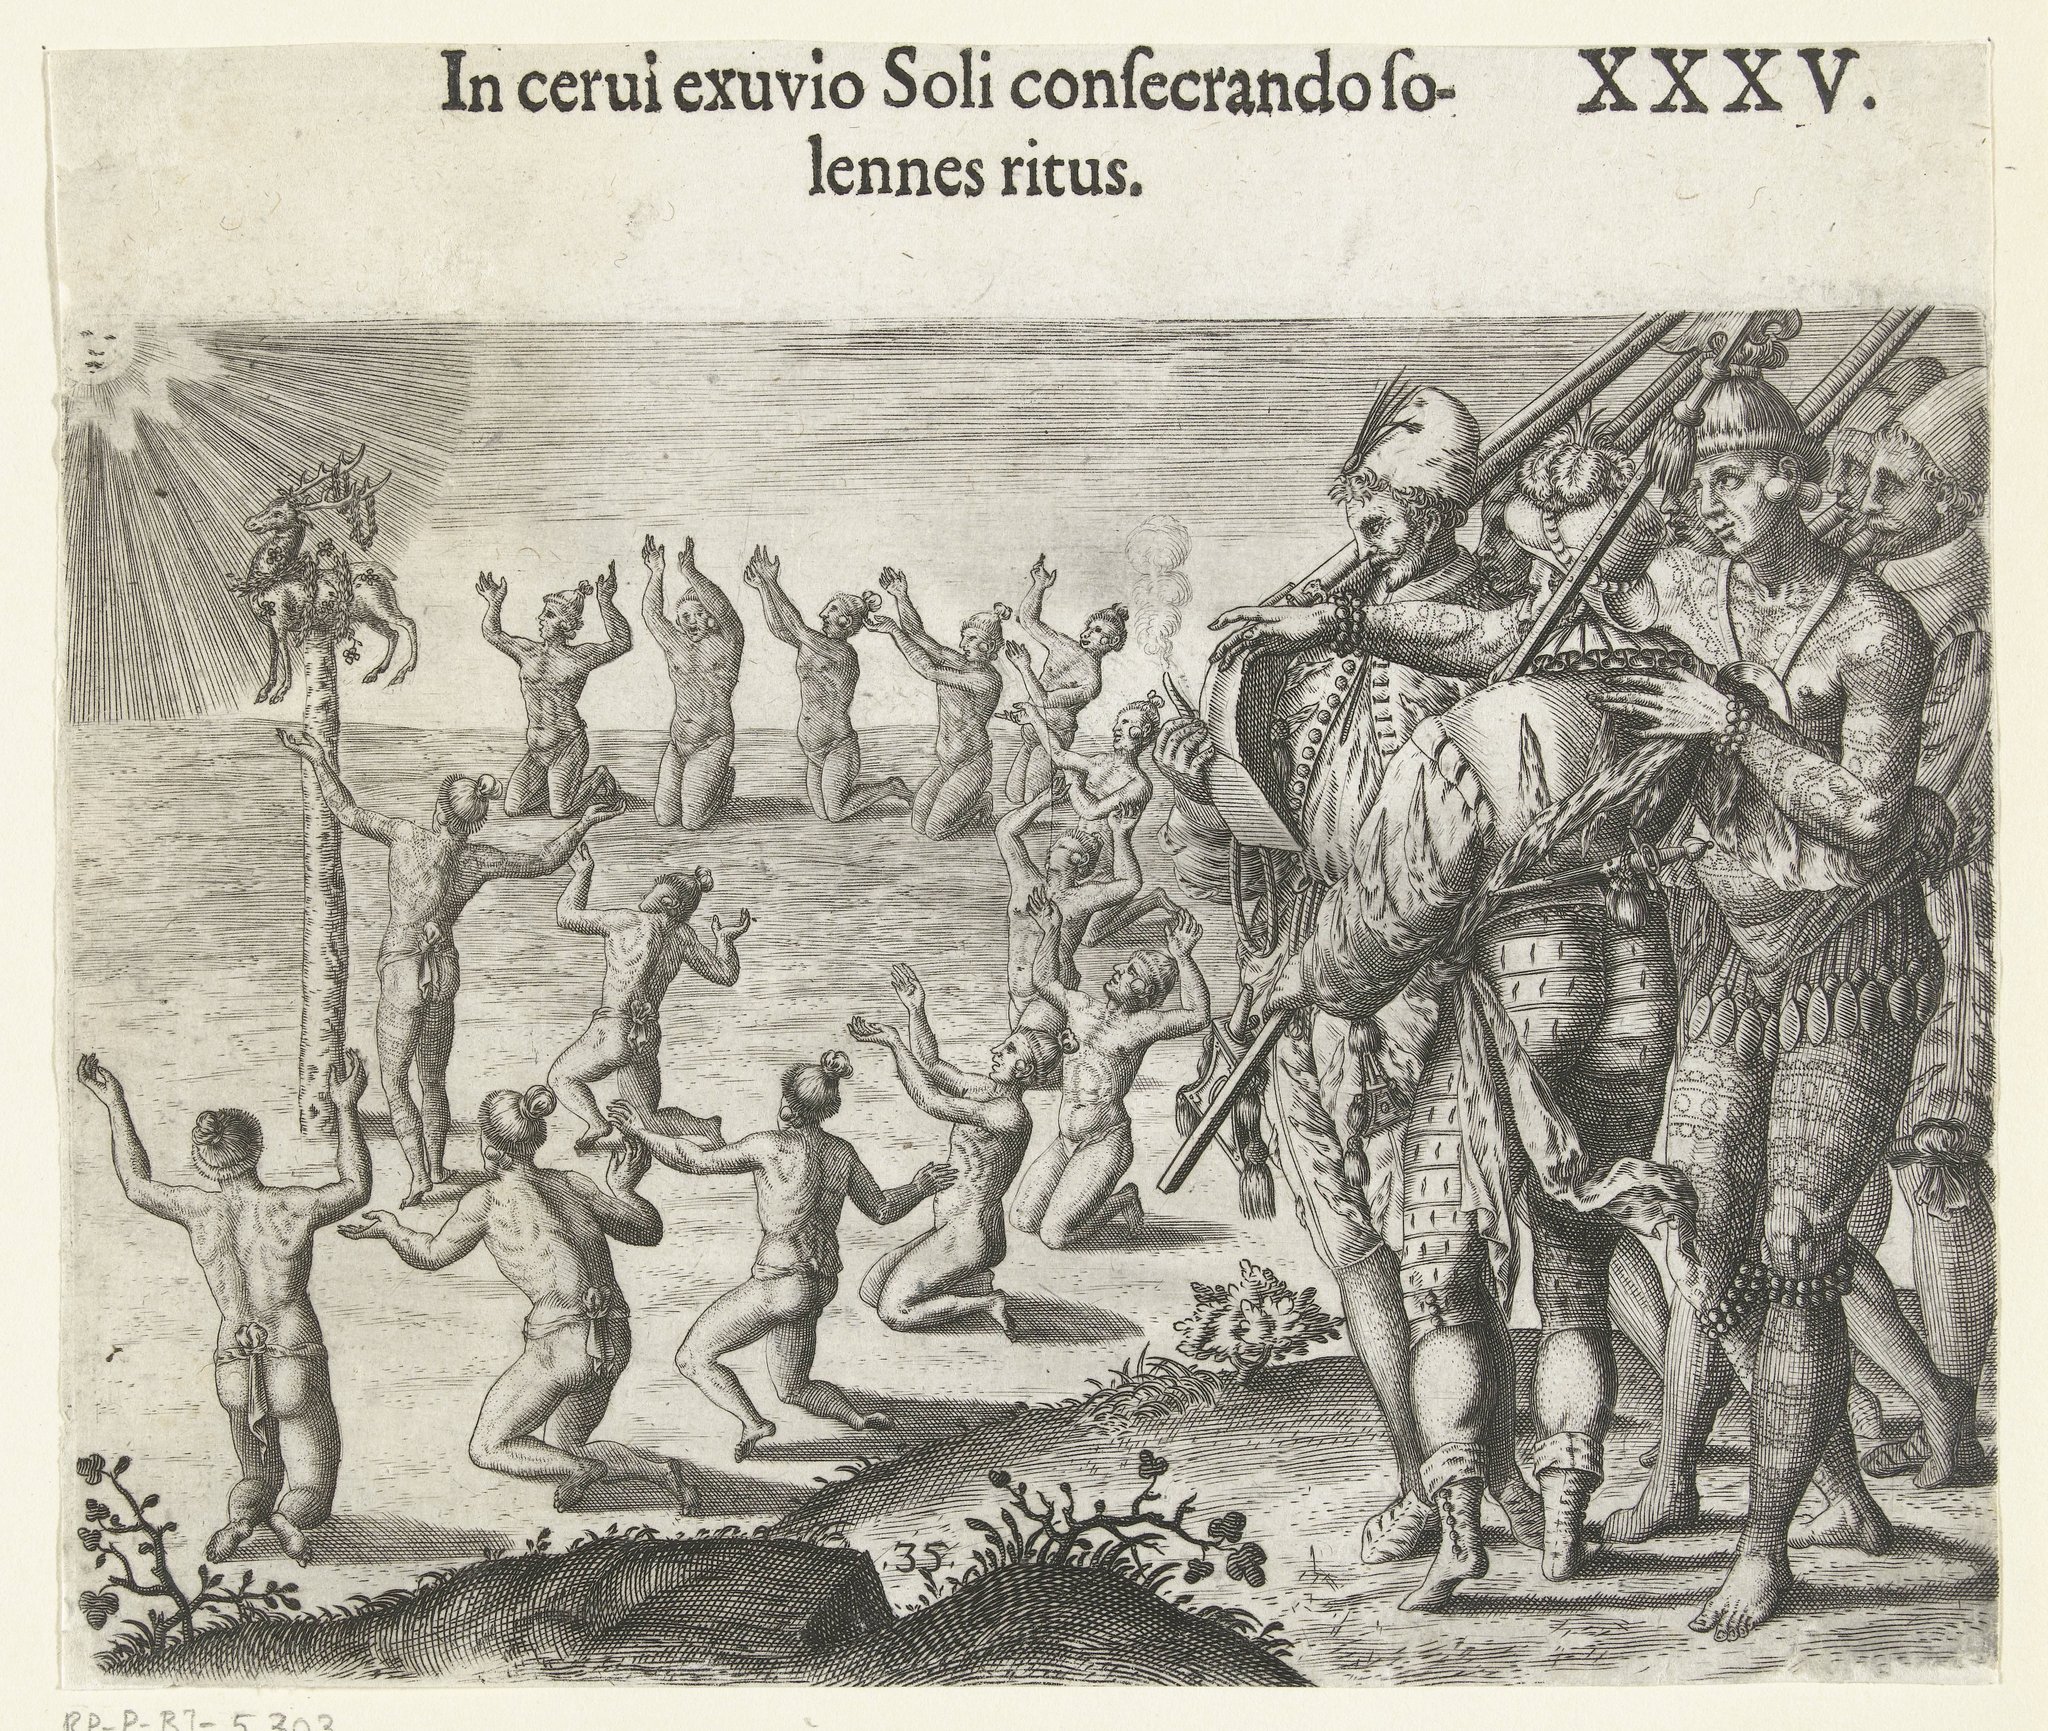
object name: print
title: India occidentalis II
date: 1591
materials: paper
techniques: engraving, letterpress printing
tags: sacrifice ~ american indian religions, worship and devotion ~ american indian religions, indigenous peoples of north america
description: De leider van het volk laat een groep Europeanen een ritueel zien. Op een stok is een hert gespiest. Het dier is versiert met bloemenkransen. Mannen dansen in een halve cirkel rond de stok en zingen. De afbeelding heeft veel weg van de verering van het gouden kalf in Exodus, waarbij nu de Joden zijn vervangen voor een volk uit Florida, mogelijk de Utina.